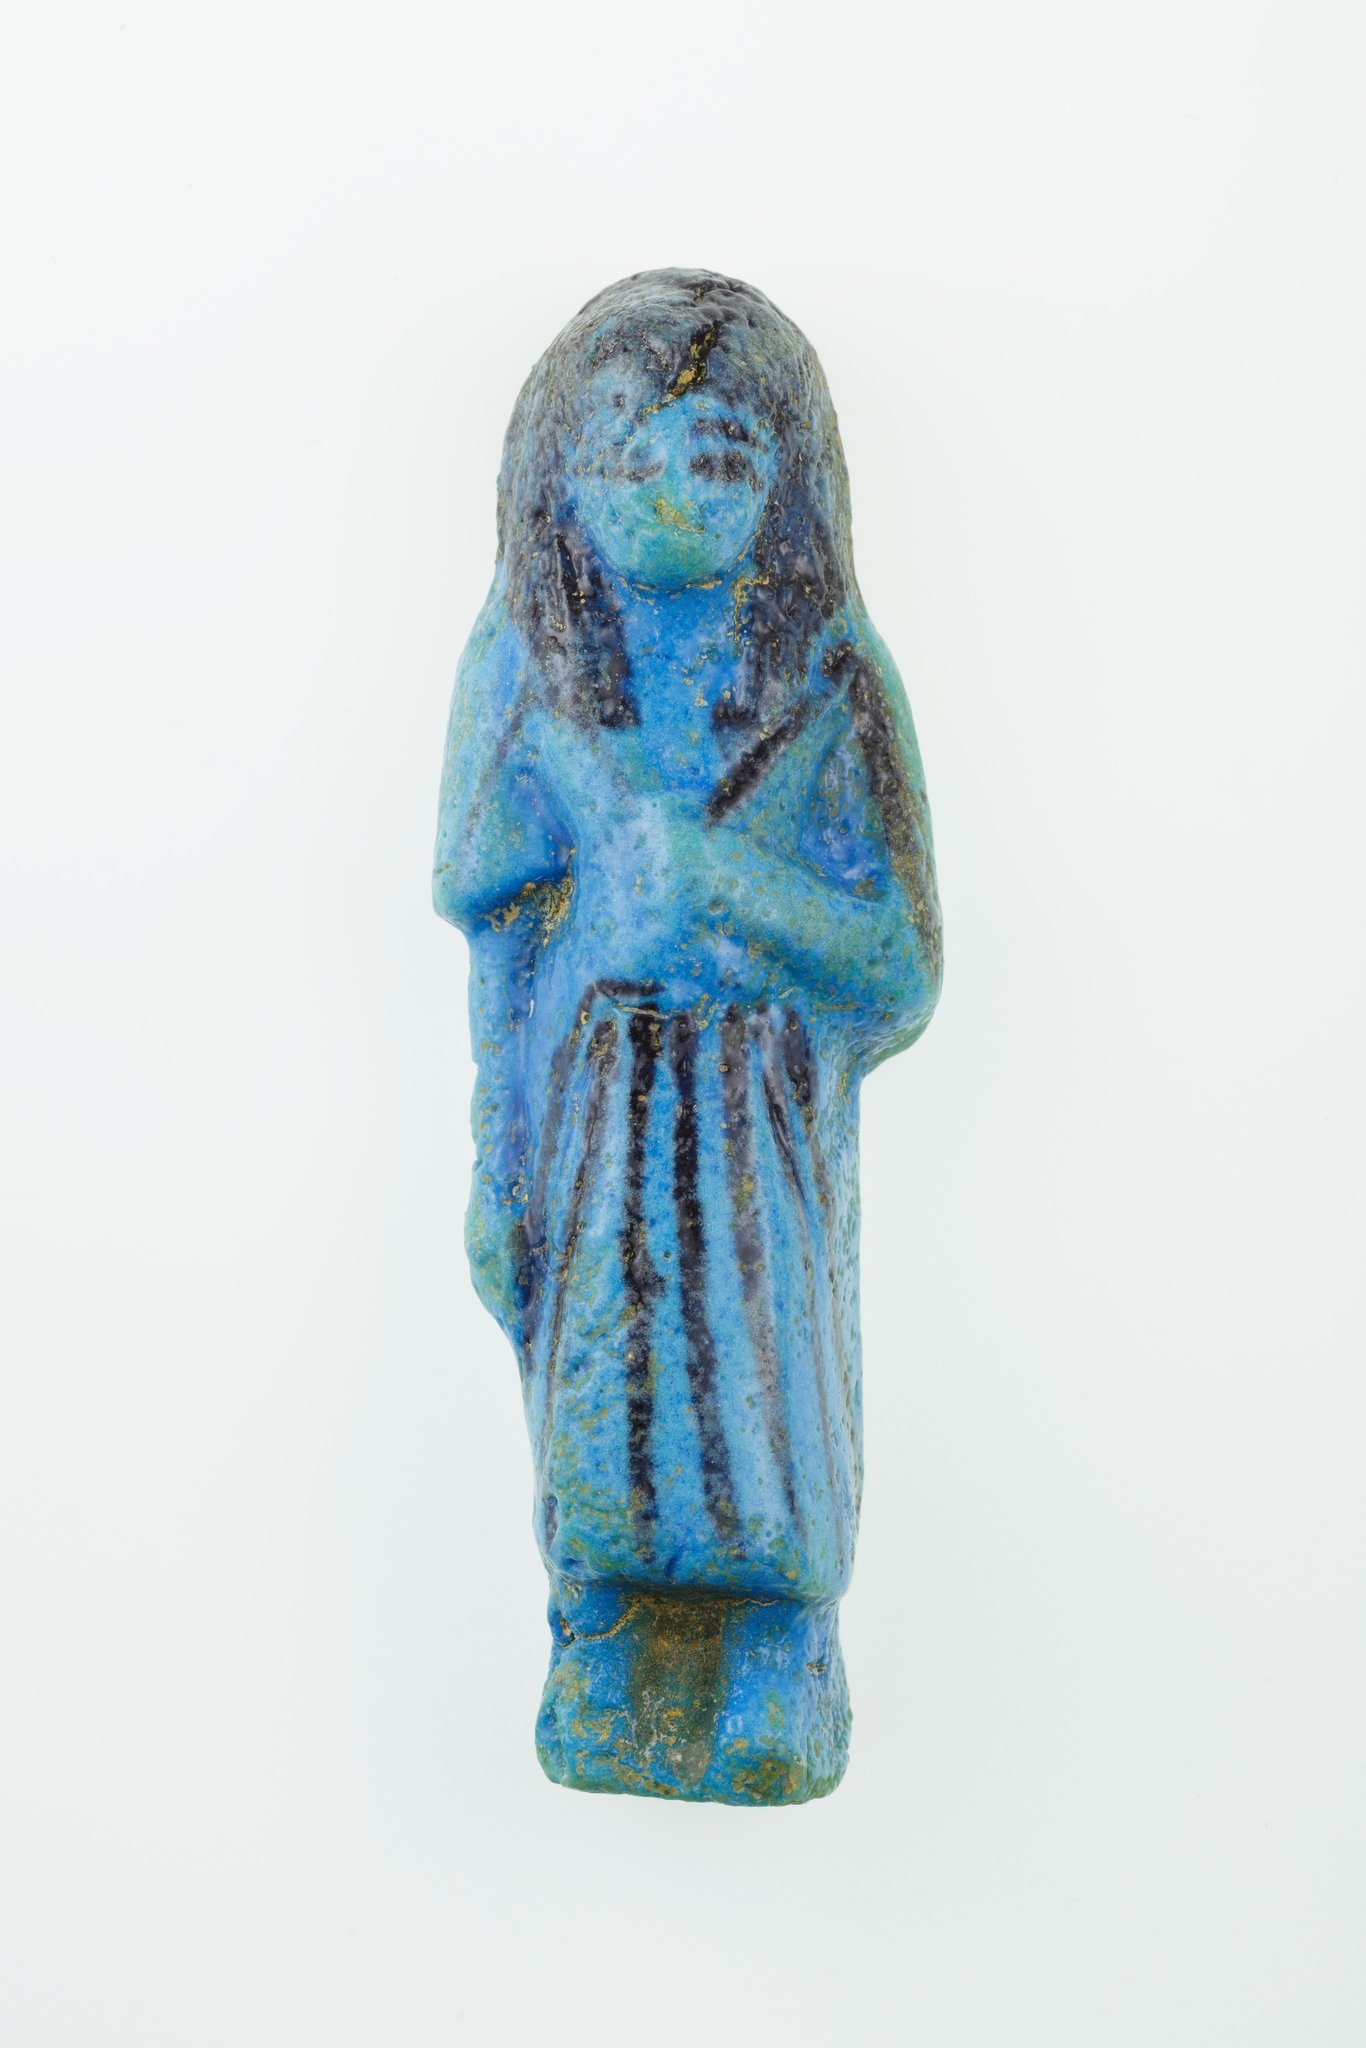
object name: shabti, overseer, nauny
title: Overseer Shabti of Nauny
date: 1050 BCE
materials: faience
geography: egypt